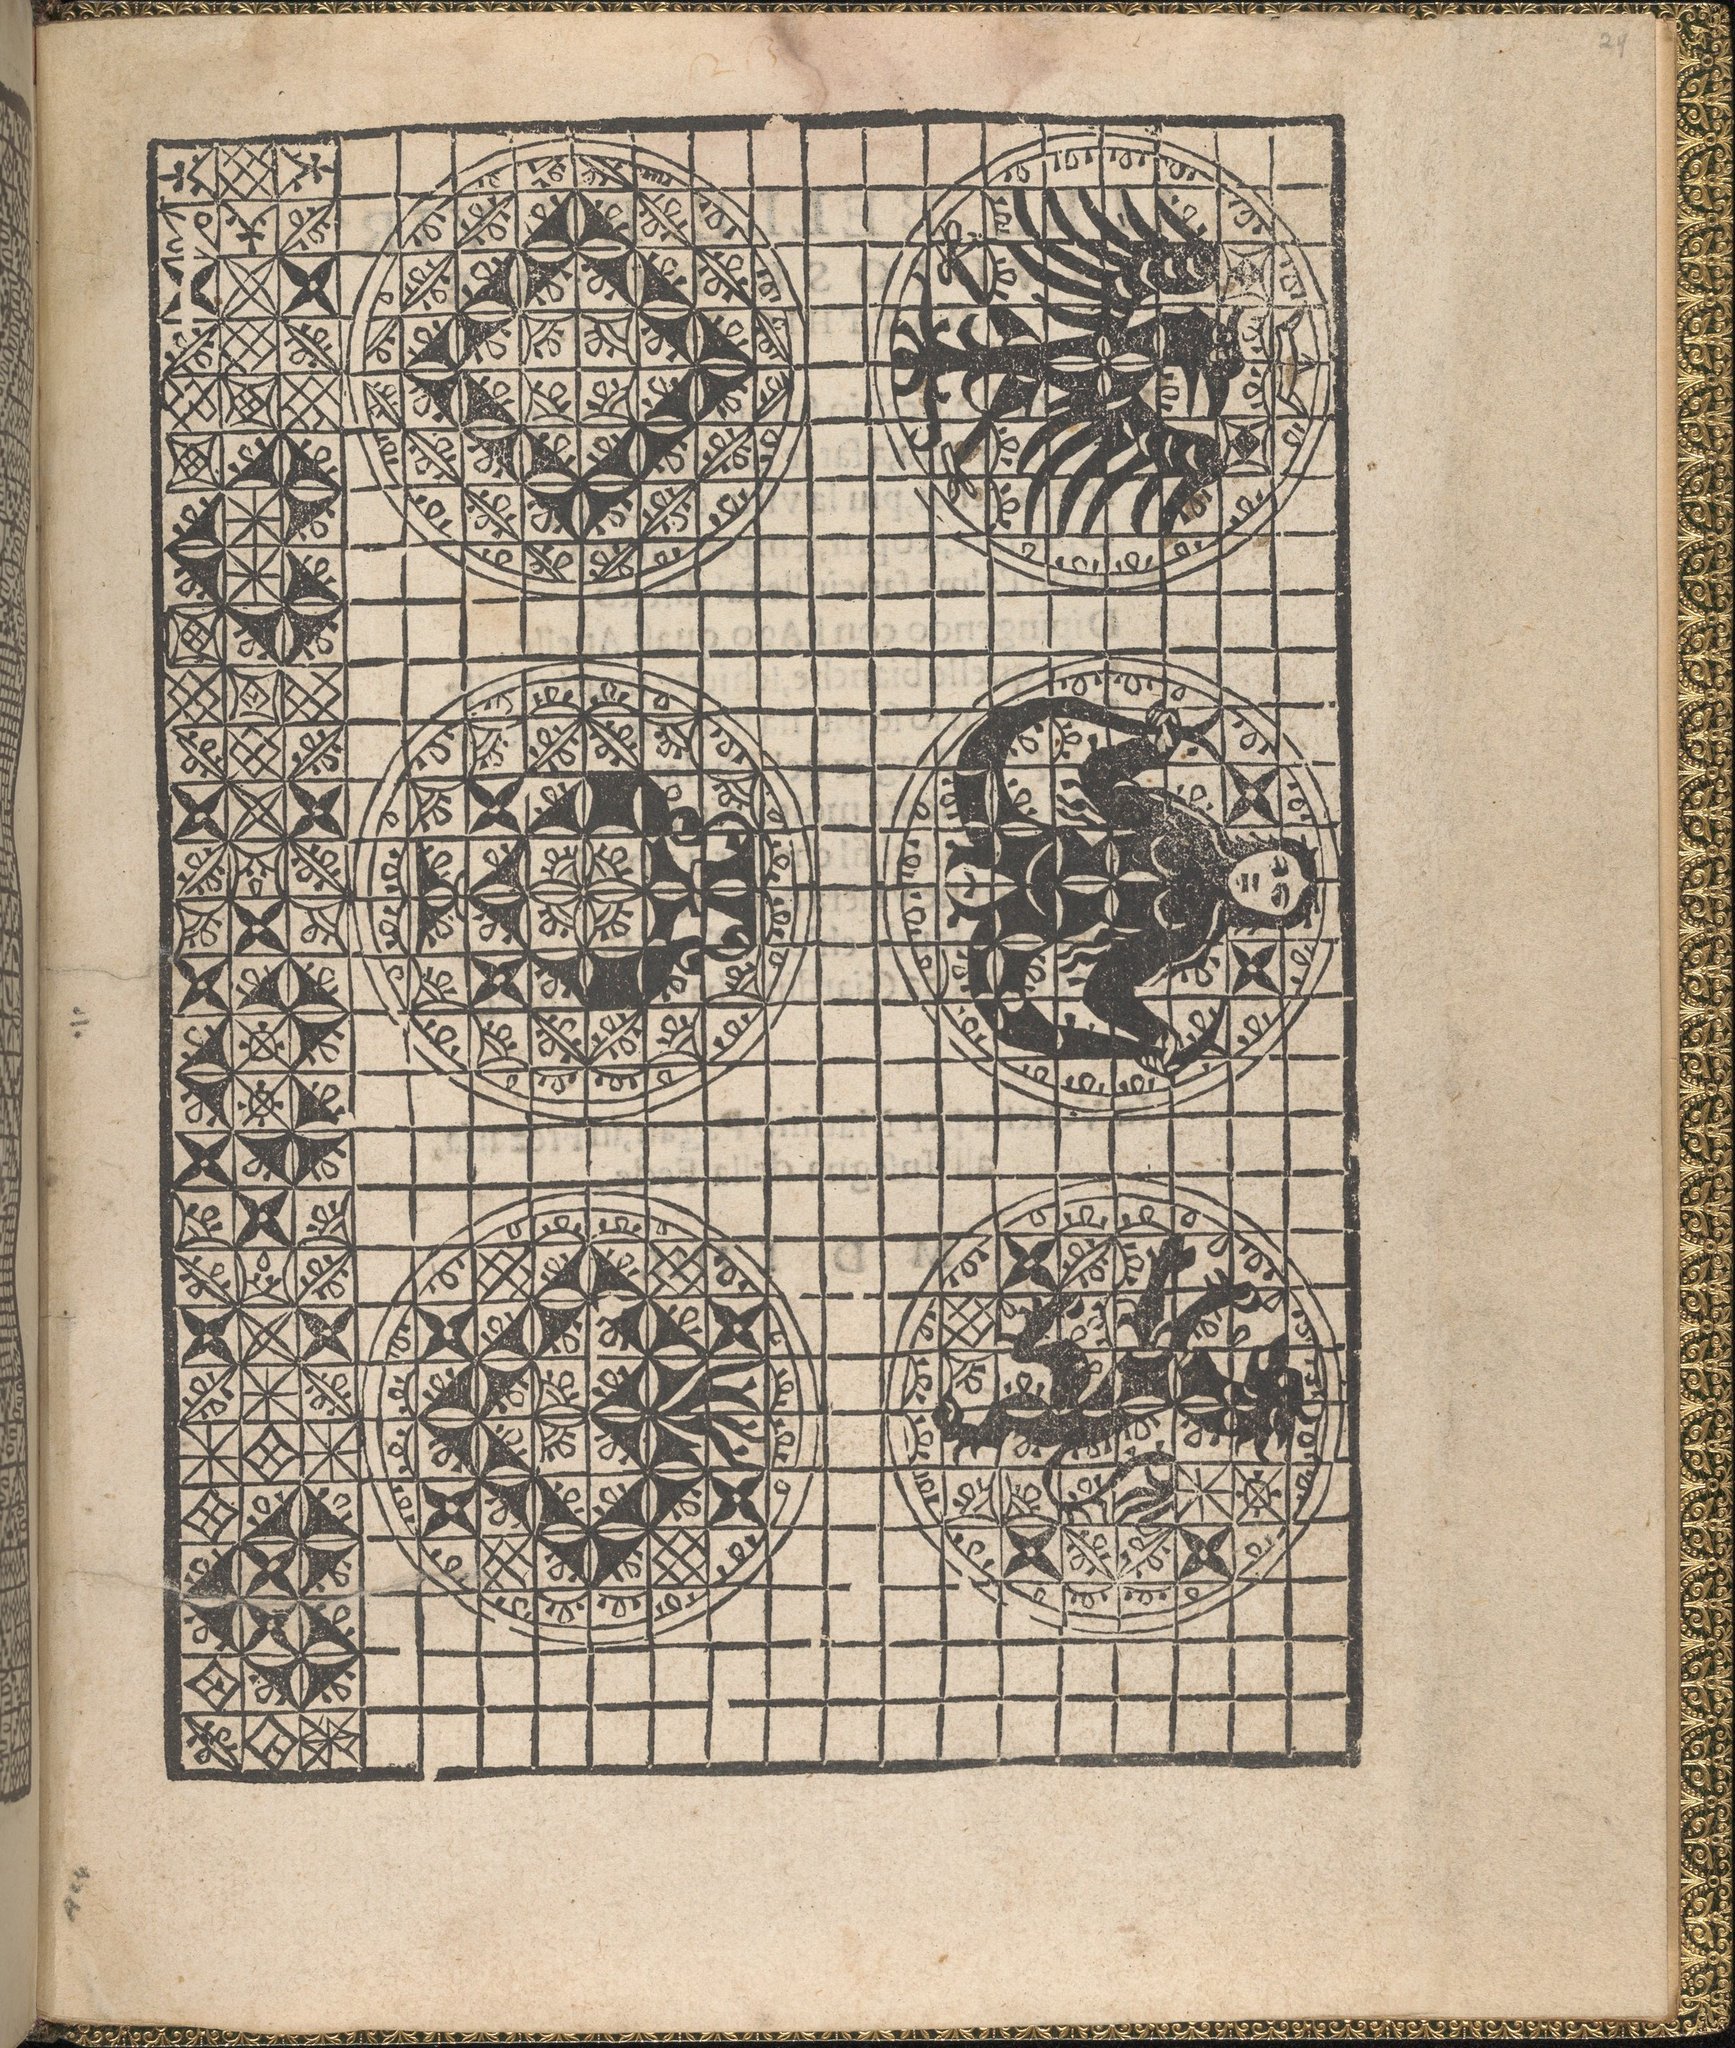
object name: book print ornament architecture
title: Giardineto novo di punti tagliati et gropposi per exercitio & ornamento delle donne (Venice 1554), page 13 (recto)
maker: matteo pagano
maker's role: publisher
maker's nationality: italian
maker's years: 1515-1588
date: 1554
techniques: woodcut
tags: ornament